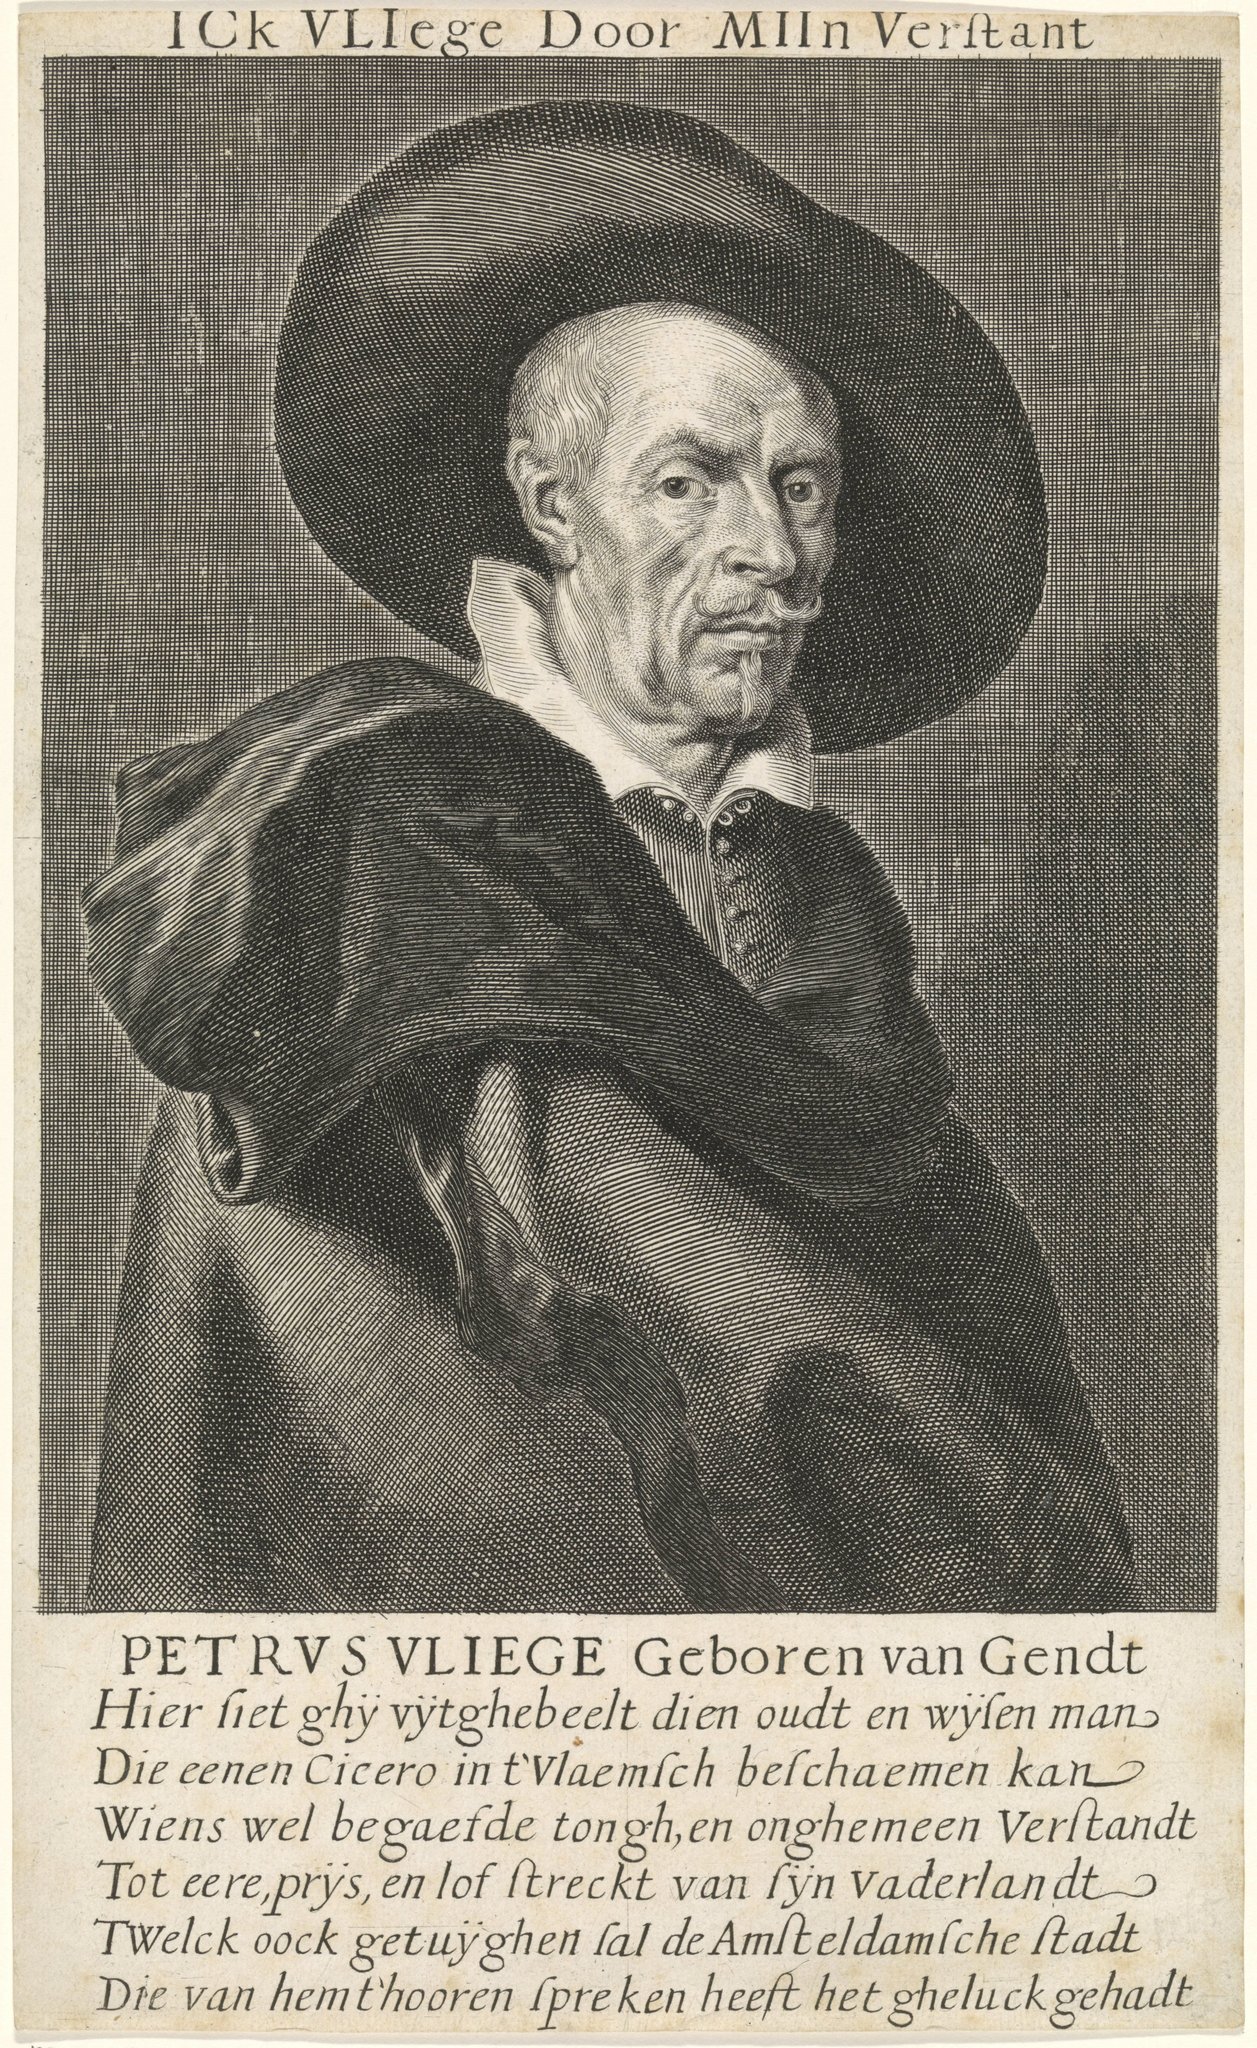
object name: print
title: Portret van Petrus Vliege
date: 1664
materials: paper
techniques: engraving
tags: ghent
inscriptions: collector's mark: Lugt 2228